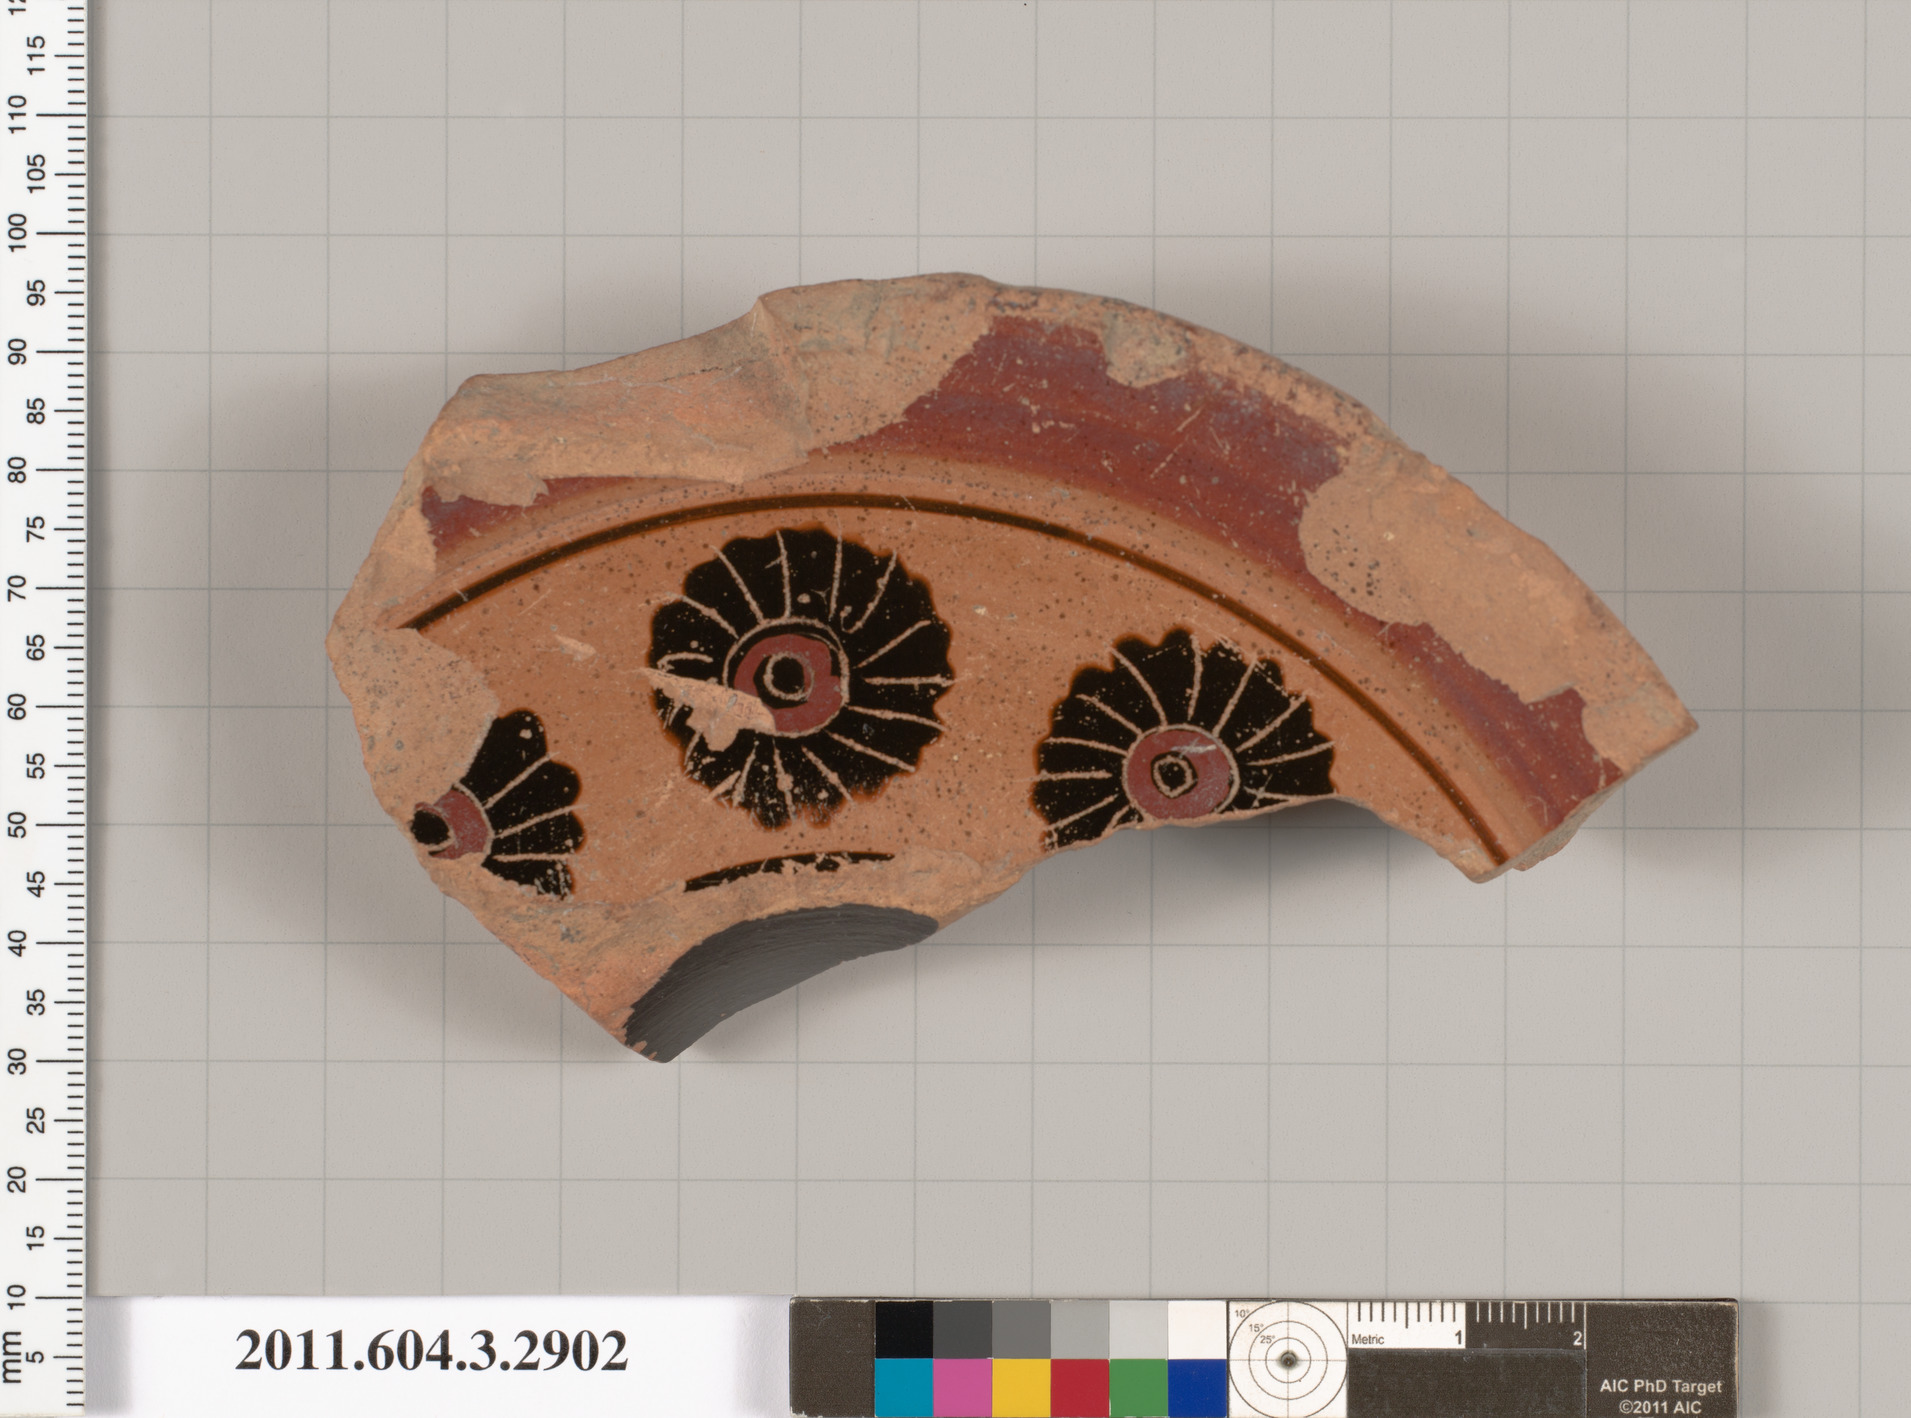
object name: loutrophoros fragment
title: Terracotta fragment of a loutrophoros (ceremonial vase for water)?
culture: greek, attic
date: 634-601 BCE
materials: terracotta